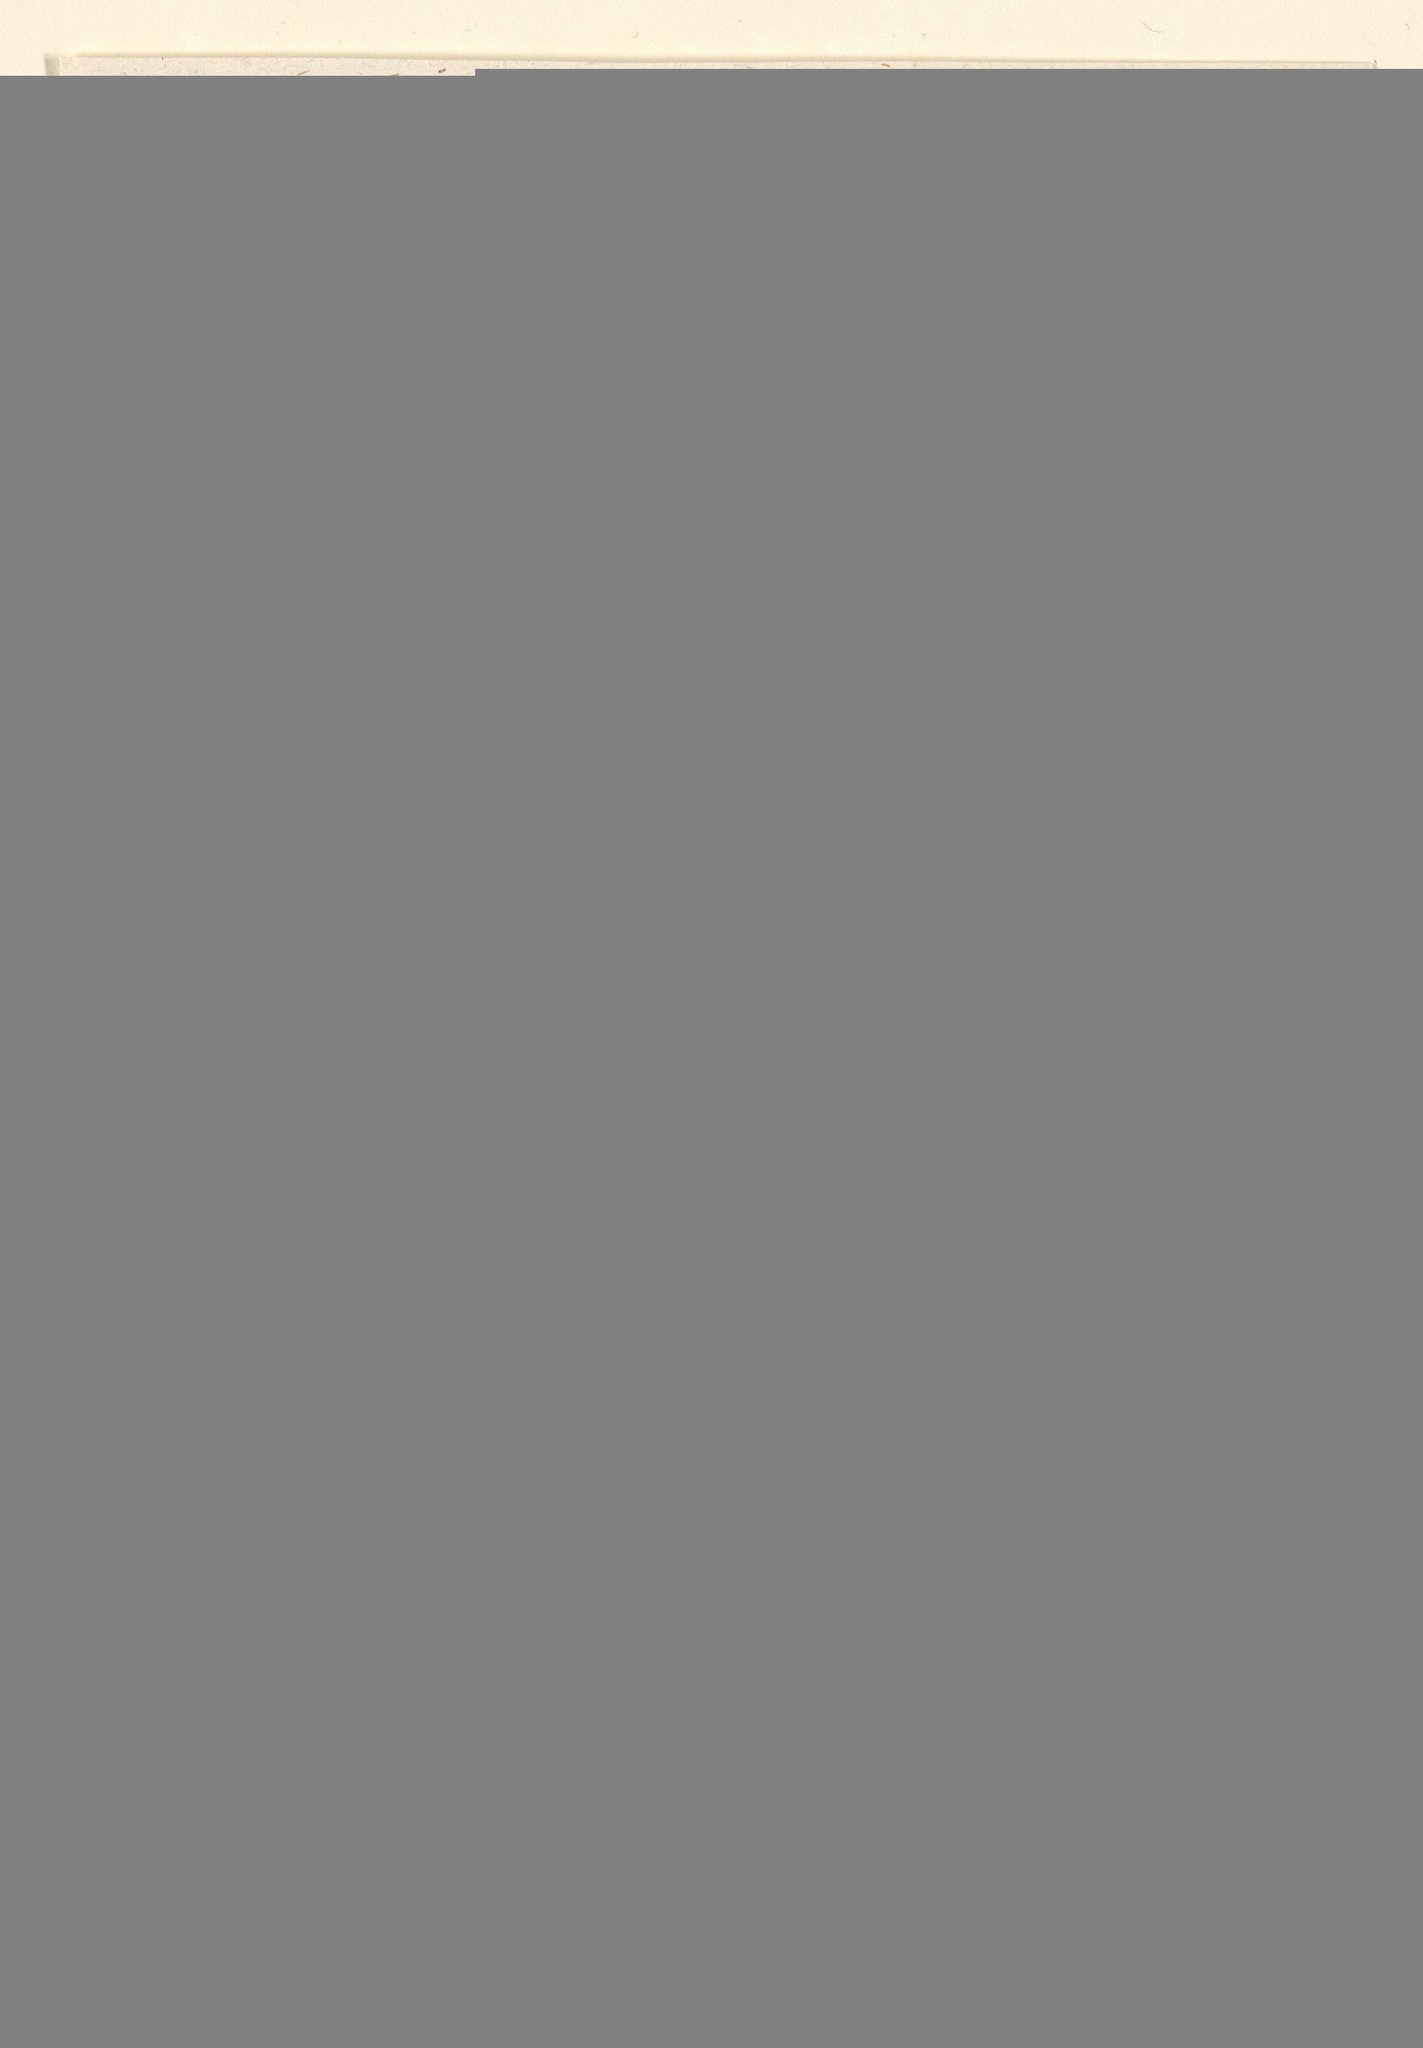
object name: print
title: Portret van Johann Christoph Wagenseil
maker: johann jacob haid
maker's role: print maker, publisher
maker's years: 1704-1767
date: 1747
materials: paper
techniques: mezzotint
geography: augsburg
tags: historical persons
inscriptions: collector's mark: Lugt 2228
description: Prent gebruikt voor: Brucker, Jacob. Ehrentempel der Deutschen Gelehrsamkeit. Augsburg: Johann Jacob Haid, 1747.